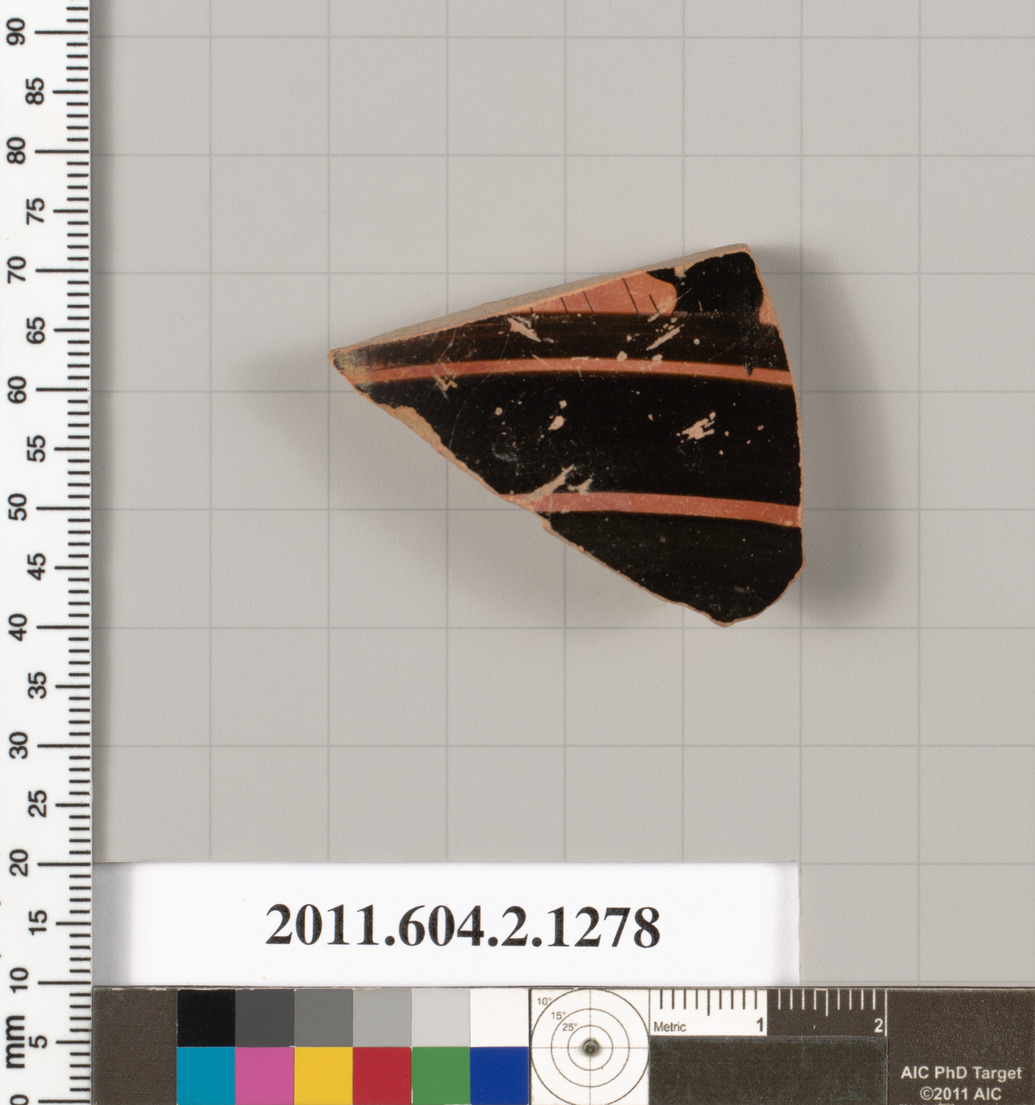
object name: skyphos fragment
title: Terracotta fragment of a skyphos (deep drinking cup)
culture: greek, attic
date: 425-401 BCE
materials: terracotta